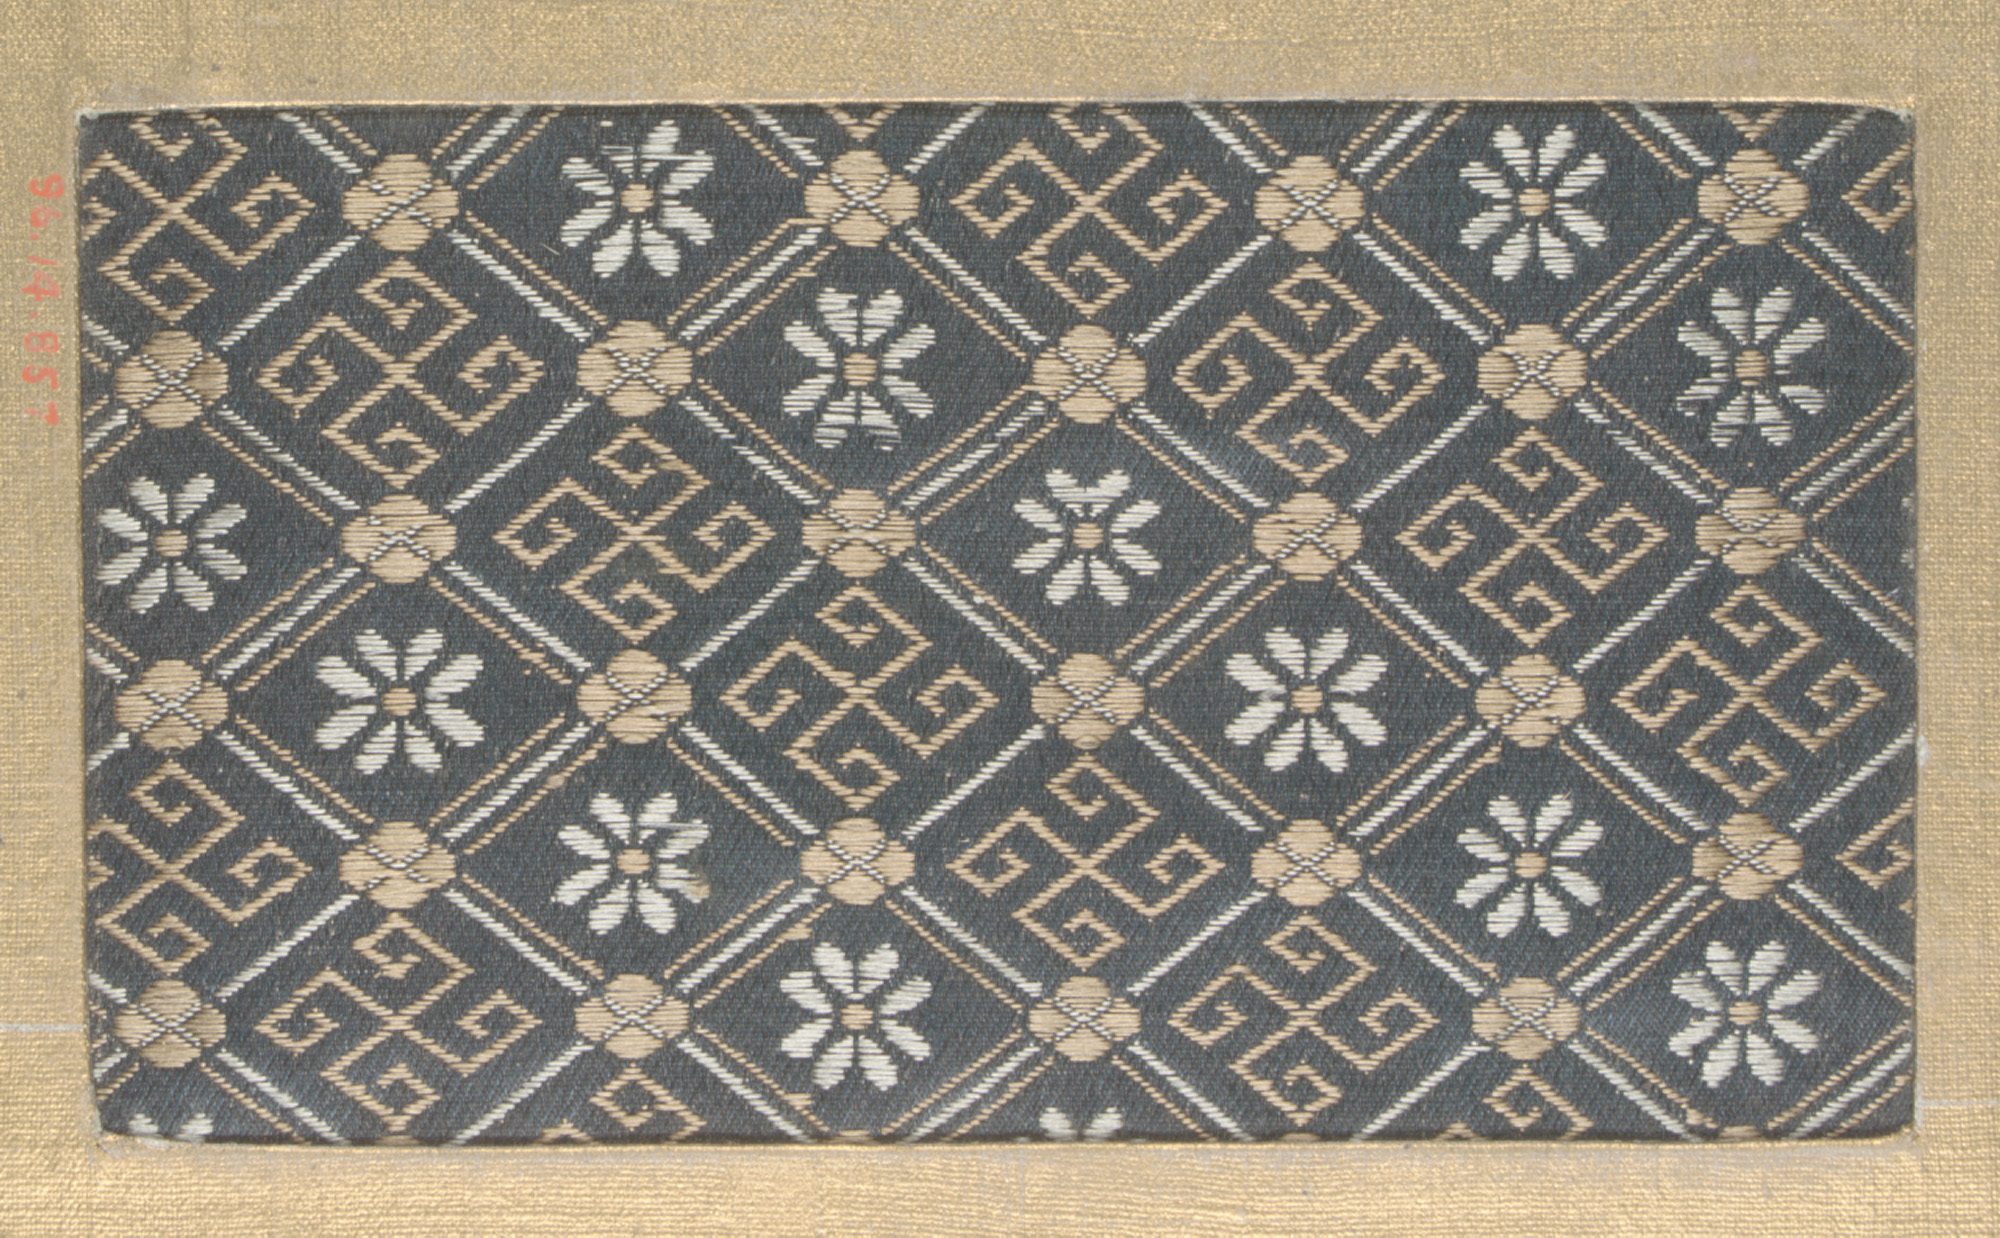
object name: piece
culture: japanese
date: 1701-1900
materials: silk